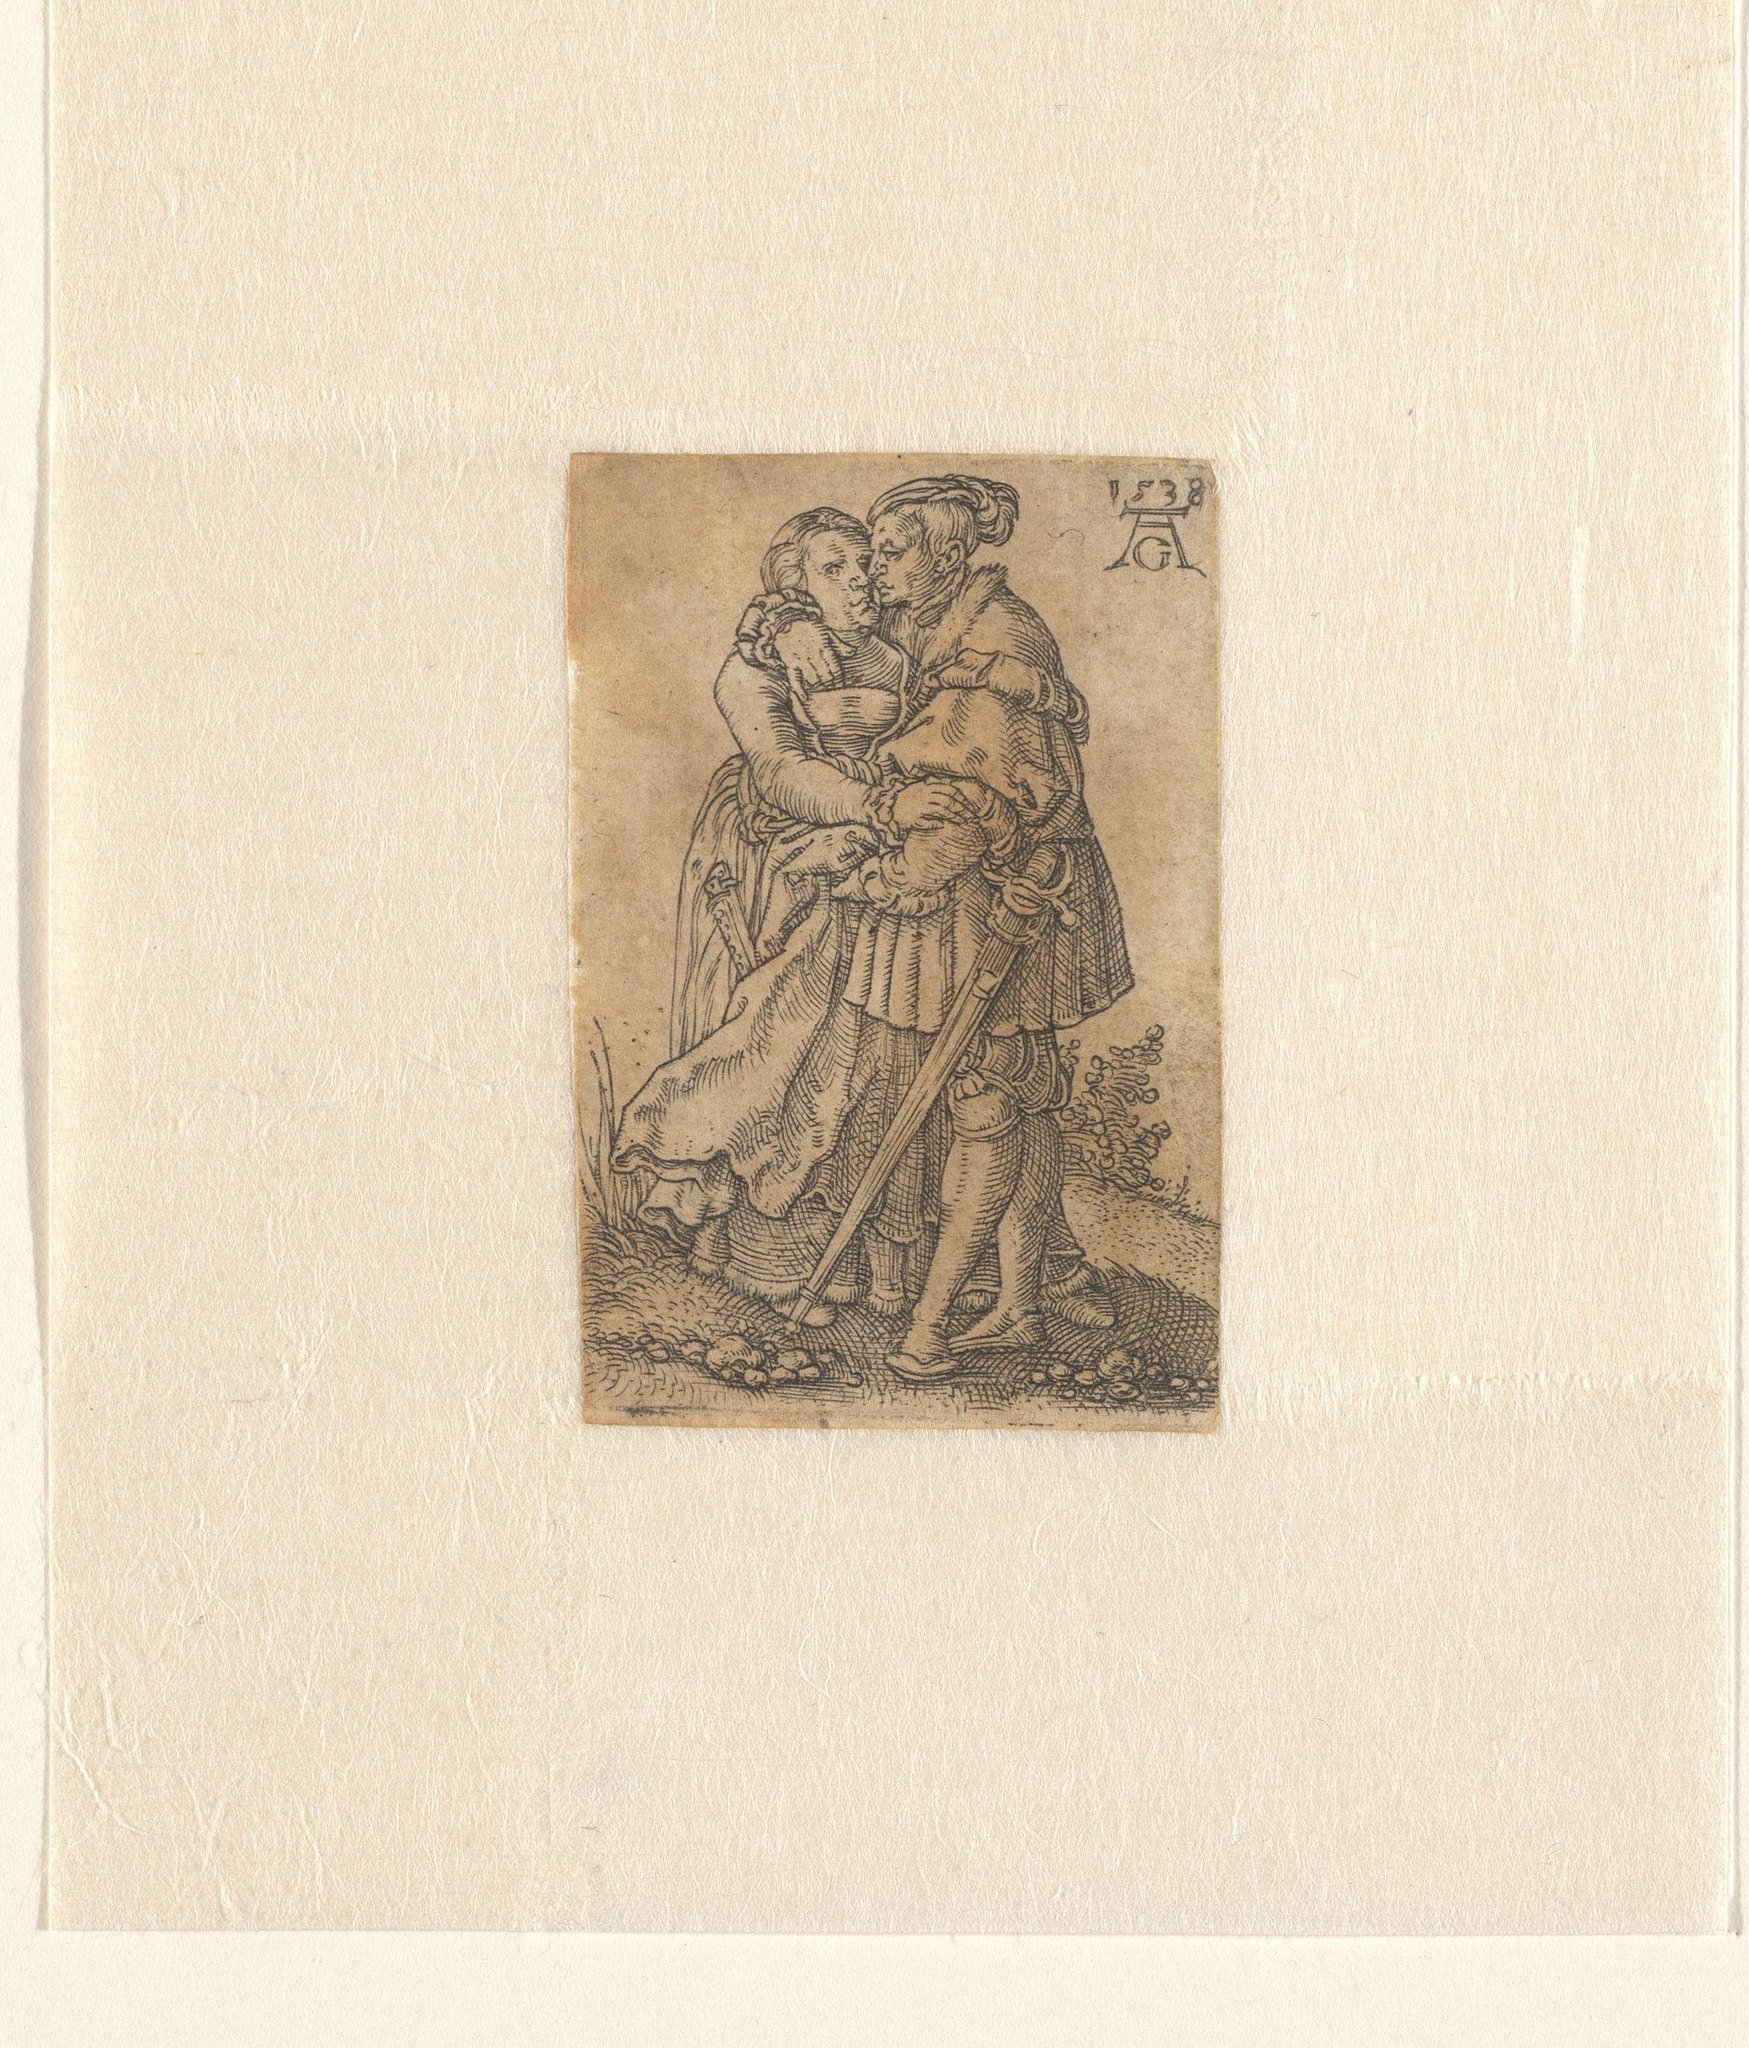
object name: print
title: Omhelzend paar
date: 1538-1580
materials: paper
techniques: engraving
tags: dancing at wedding feast, one pair dancing; man and woman dancing as a couple